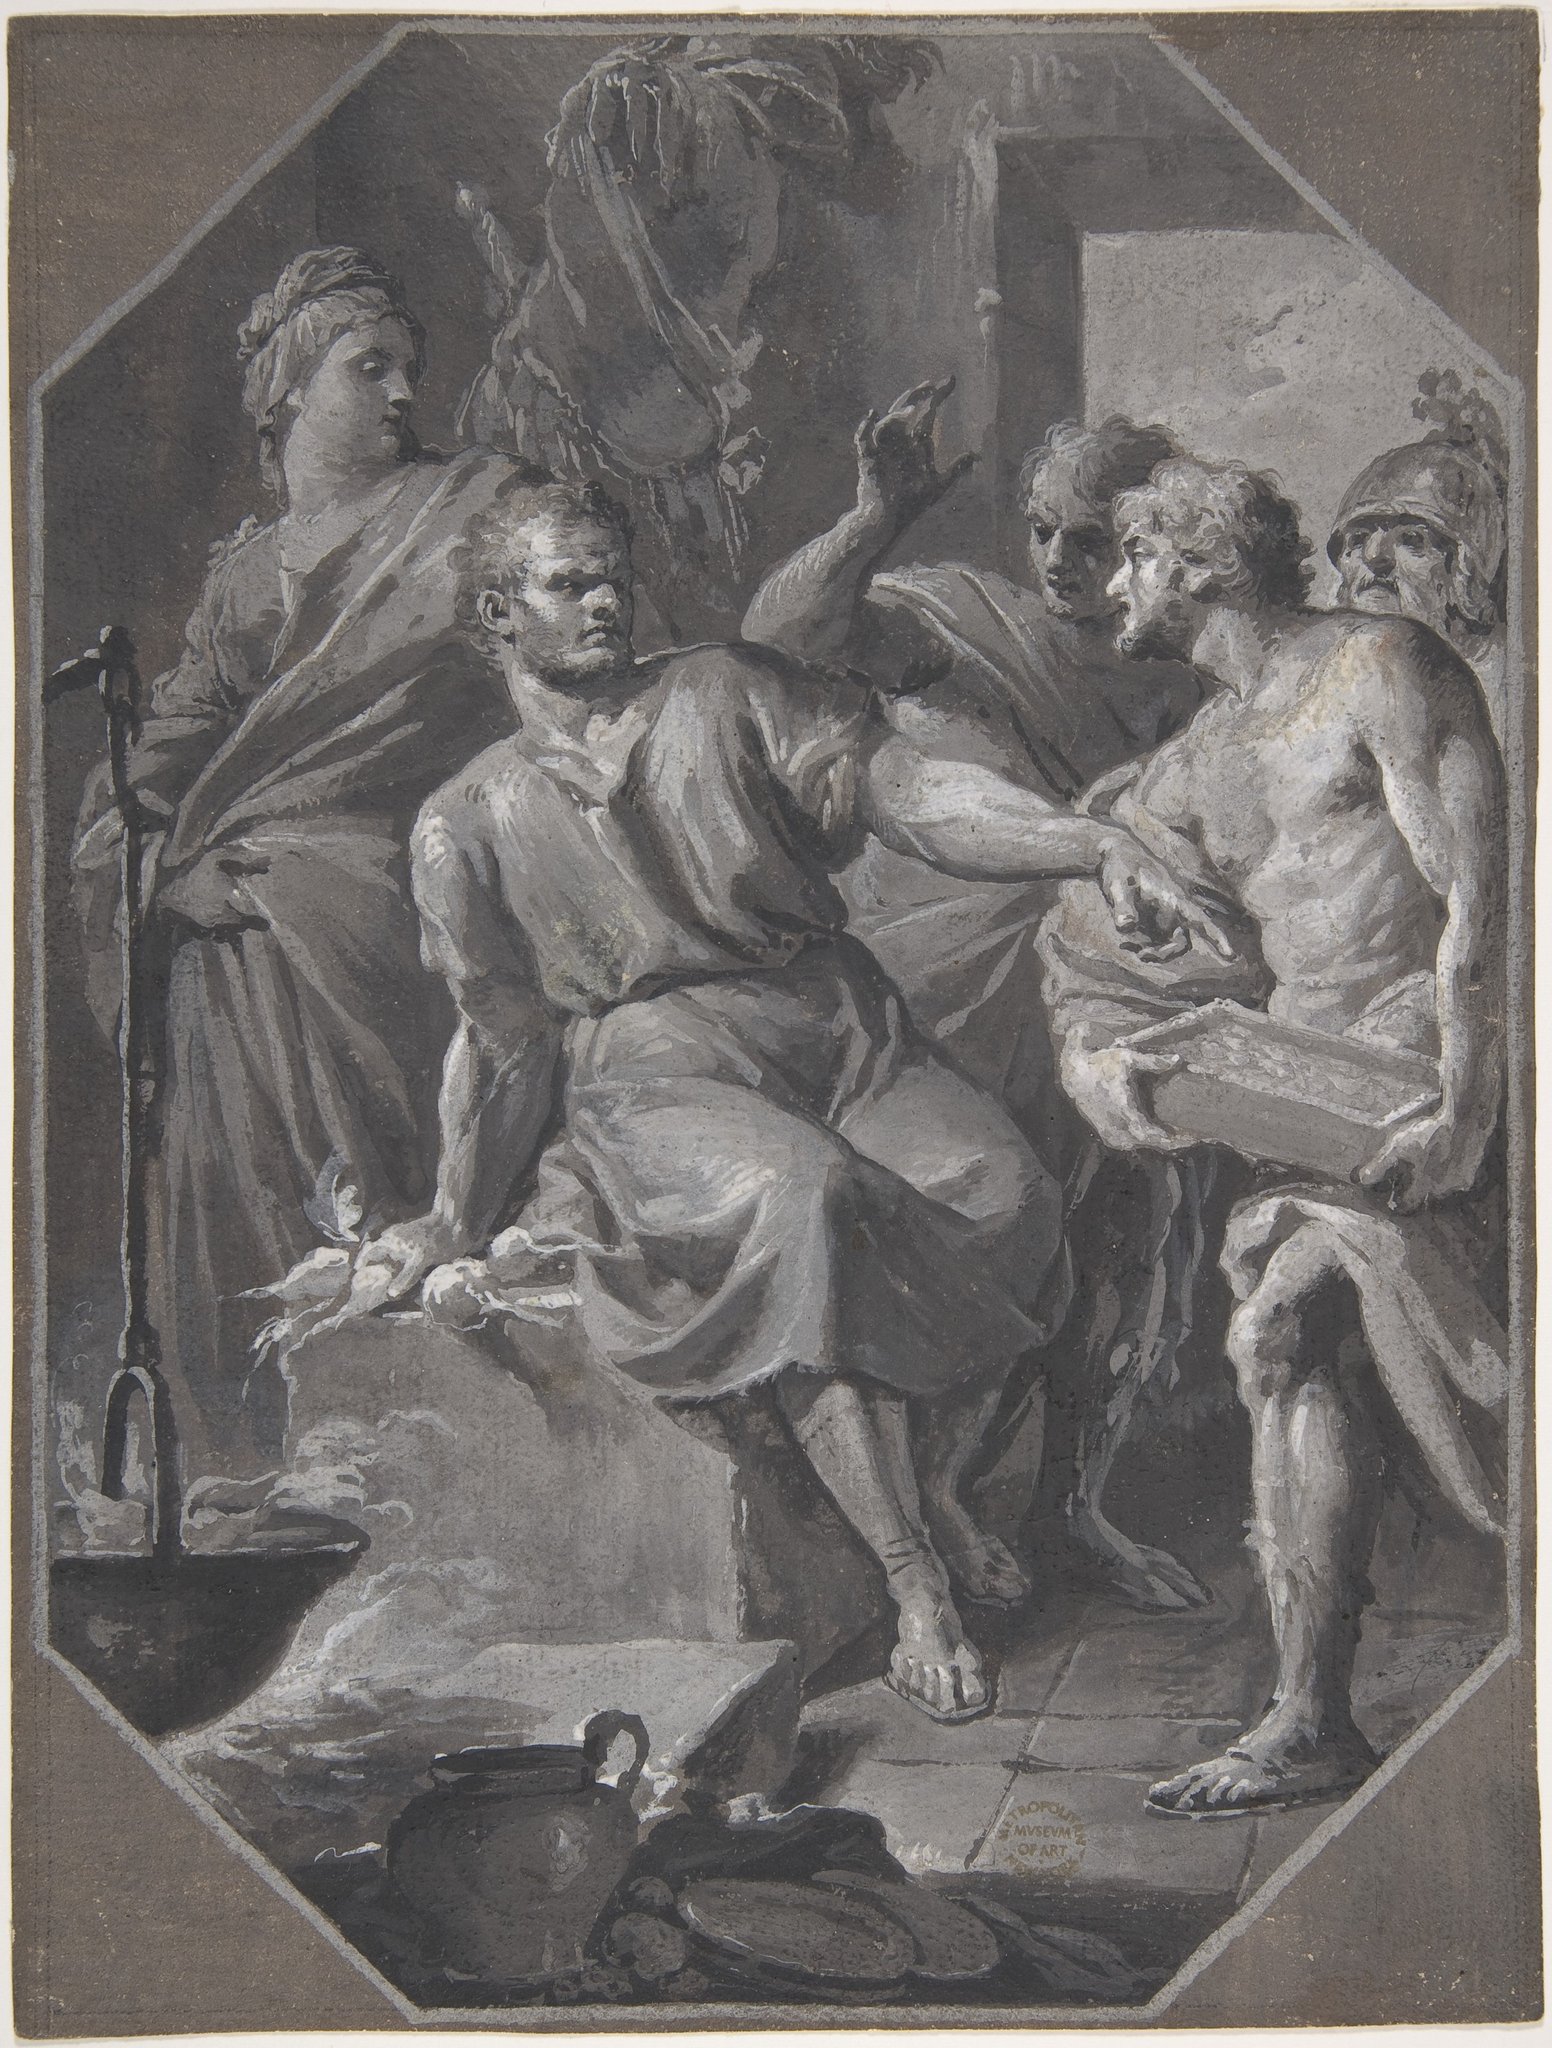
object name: drawing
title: Manius Curius Dentatus Refusing the Presents of the Samnite Ambassadors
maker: fedele fischetti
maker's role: artist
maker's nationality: italian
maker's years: 1732-1792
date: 1732-1792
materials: gouache, paper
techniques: brush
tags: men,women